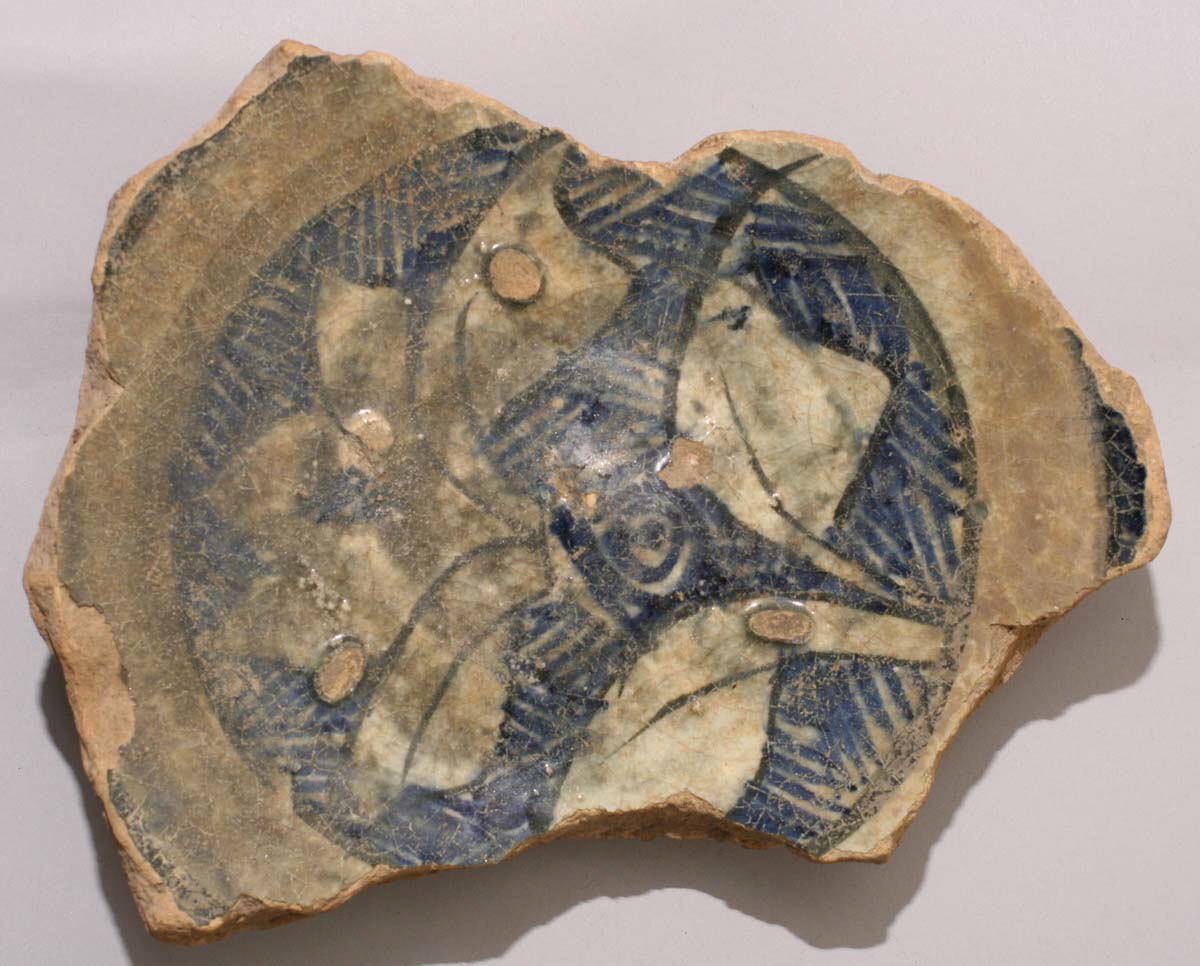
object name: fragment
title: Fragment of a Bowl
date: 1301-1500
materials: glaze, stonepaste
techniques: underglaze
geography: egypt